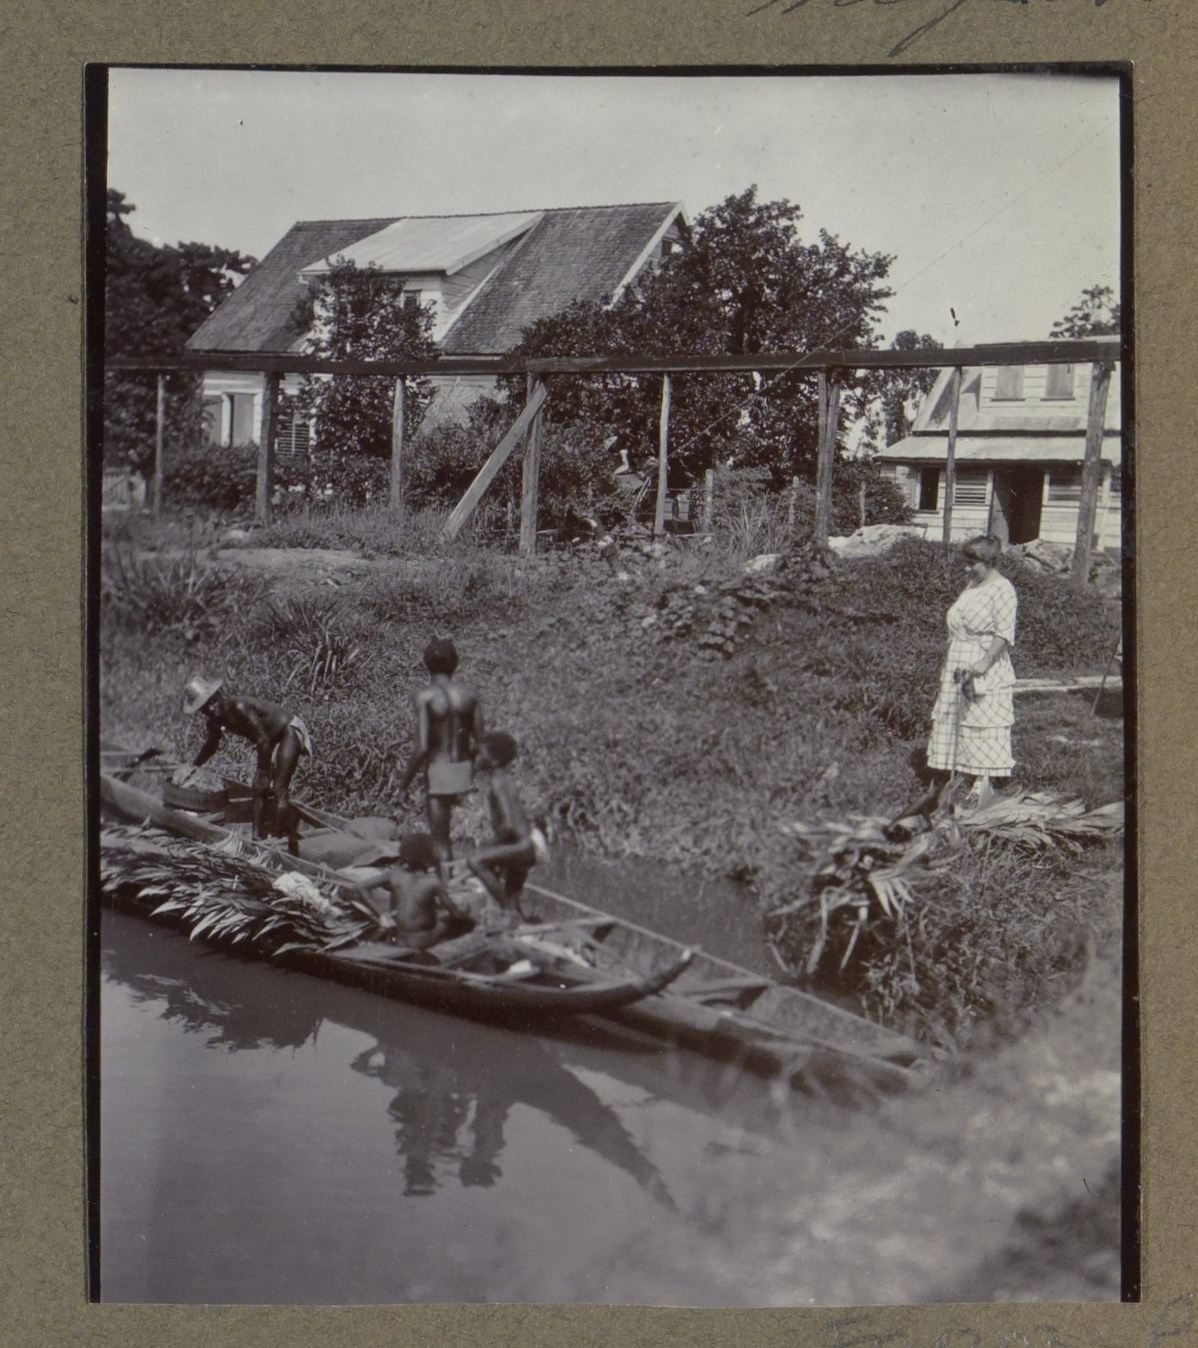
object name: photograph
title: Vrouw kijkt naar Marrons in een boot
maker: Anonymous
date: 1920-1930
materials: photographic support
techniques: gelatin silver print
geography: suriname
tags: rowing-boat, canoe, etc., suriname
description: Onderdeel van fotoalbum van een onbekende Nederlandse familie met opnames van Suriname, Europa en Nederlands-Indië.